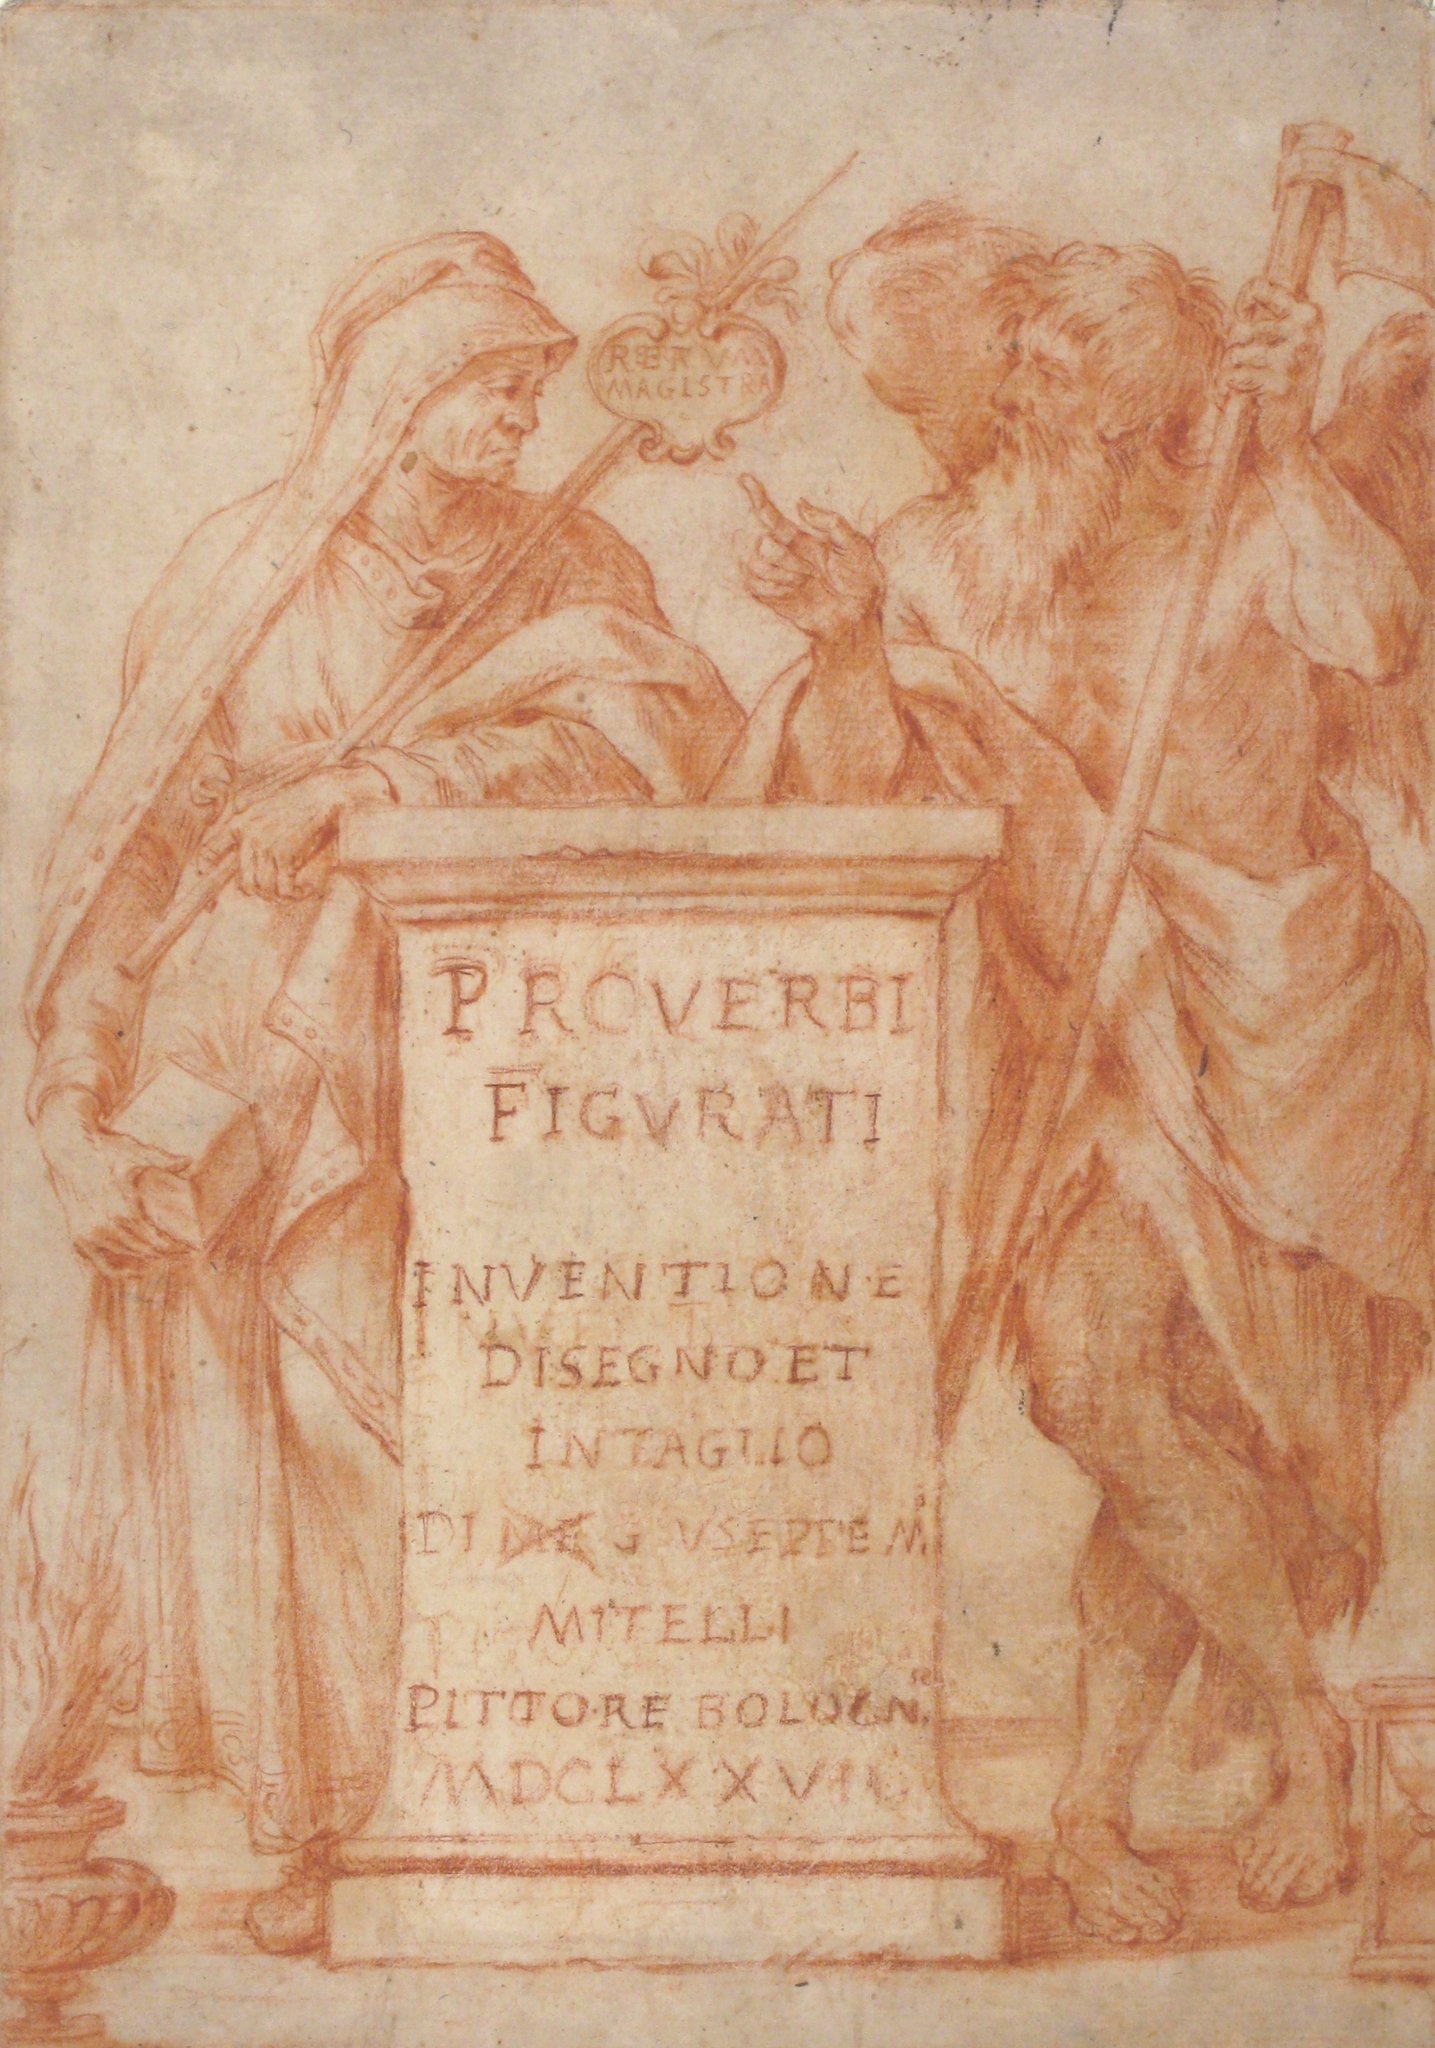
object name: drawing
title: Allegorical Figures of Experience and Time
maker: giuseppe maria mitelli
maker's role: artist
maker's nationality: italian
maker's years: 1634-1718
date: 1677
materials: chalk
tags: men,women